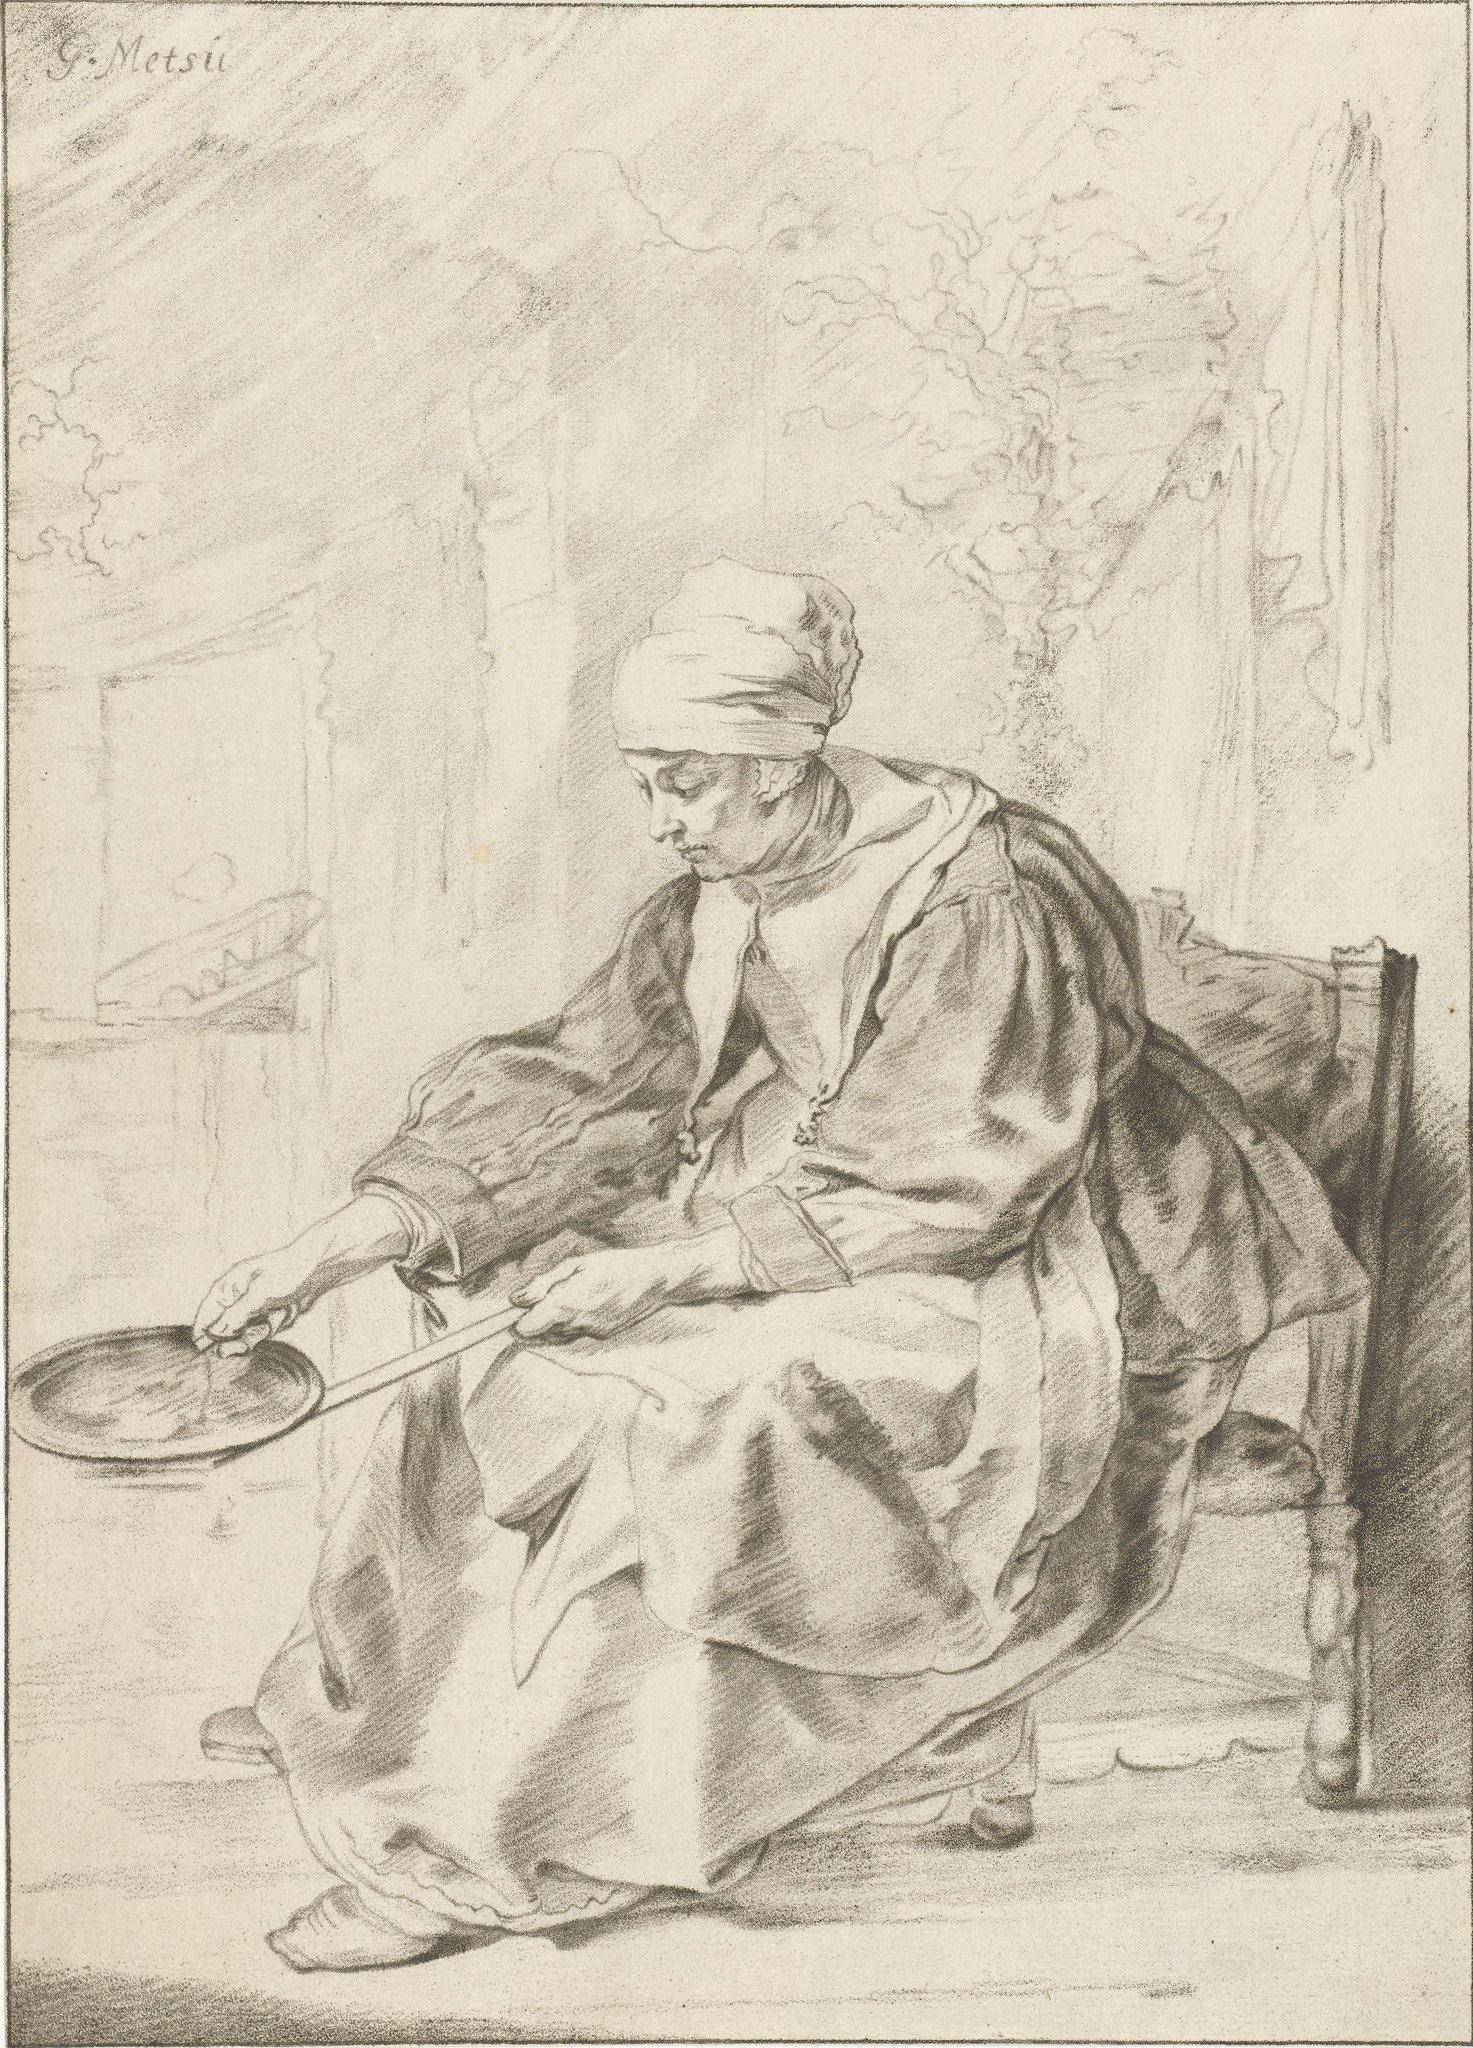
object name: print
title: Pannenkoekenbakster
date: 1768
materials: paper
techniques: printmaking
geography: amsterdam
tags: pancakes, adult woman, cooking food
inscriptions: inscription: ‘G. Metsu. del. Ploos van Amstel. Fecit. 1768.’, collector's mark: Lugt 2725, collector's mark: Lugt 240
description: Een vrouw, zittend op een stoel bij een oven, met een koekenpan in haar hand.